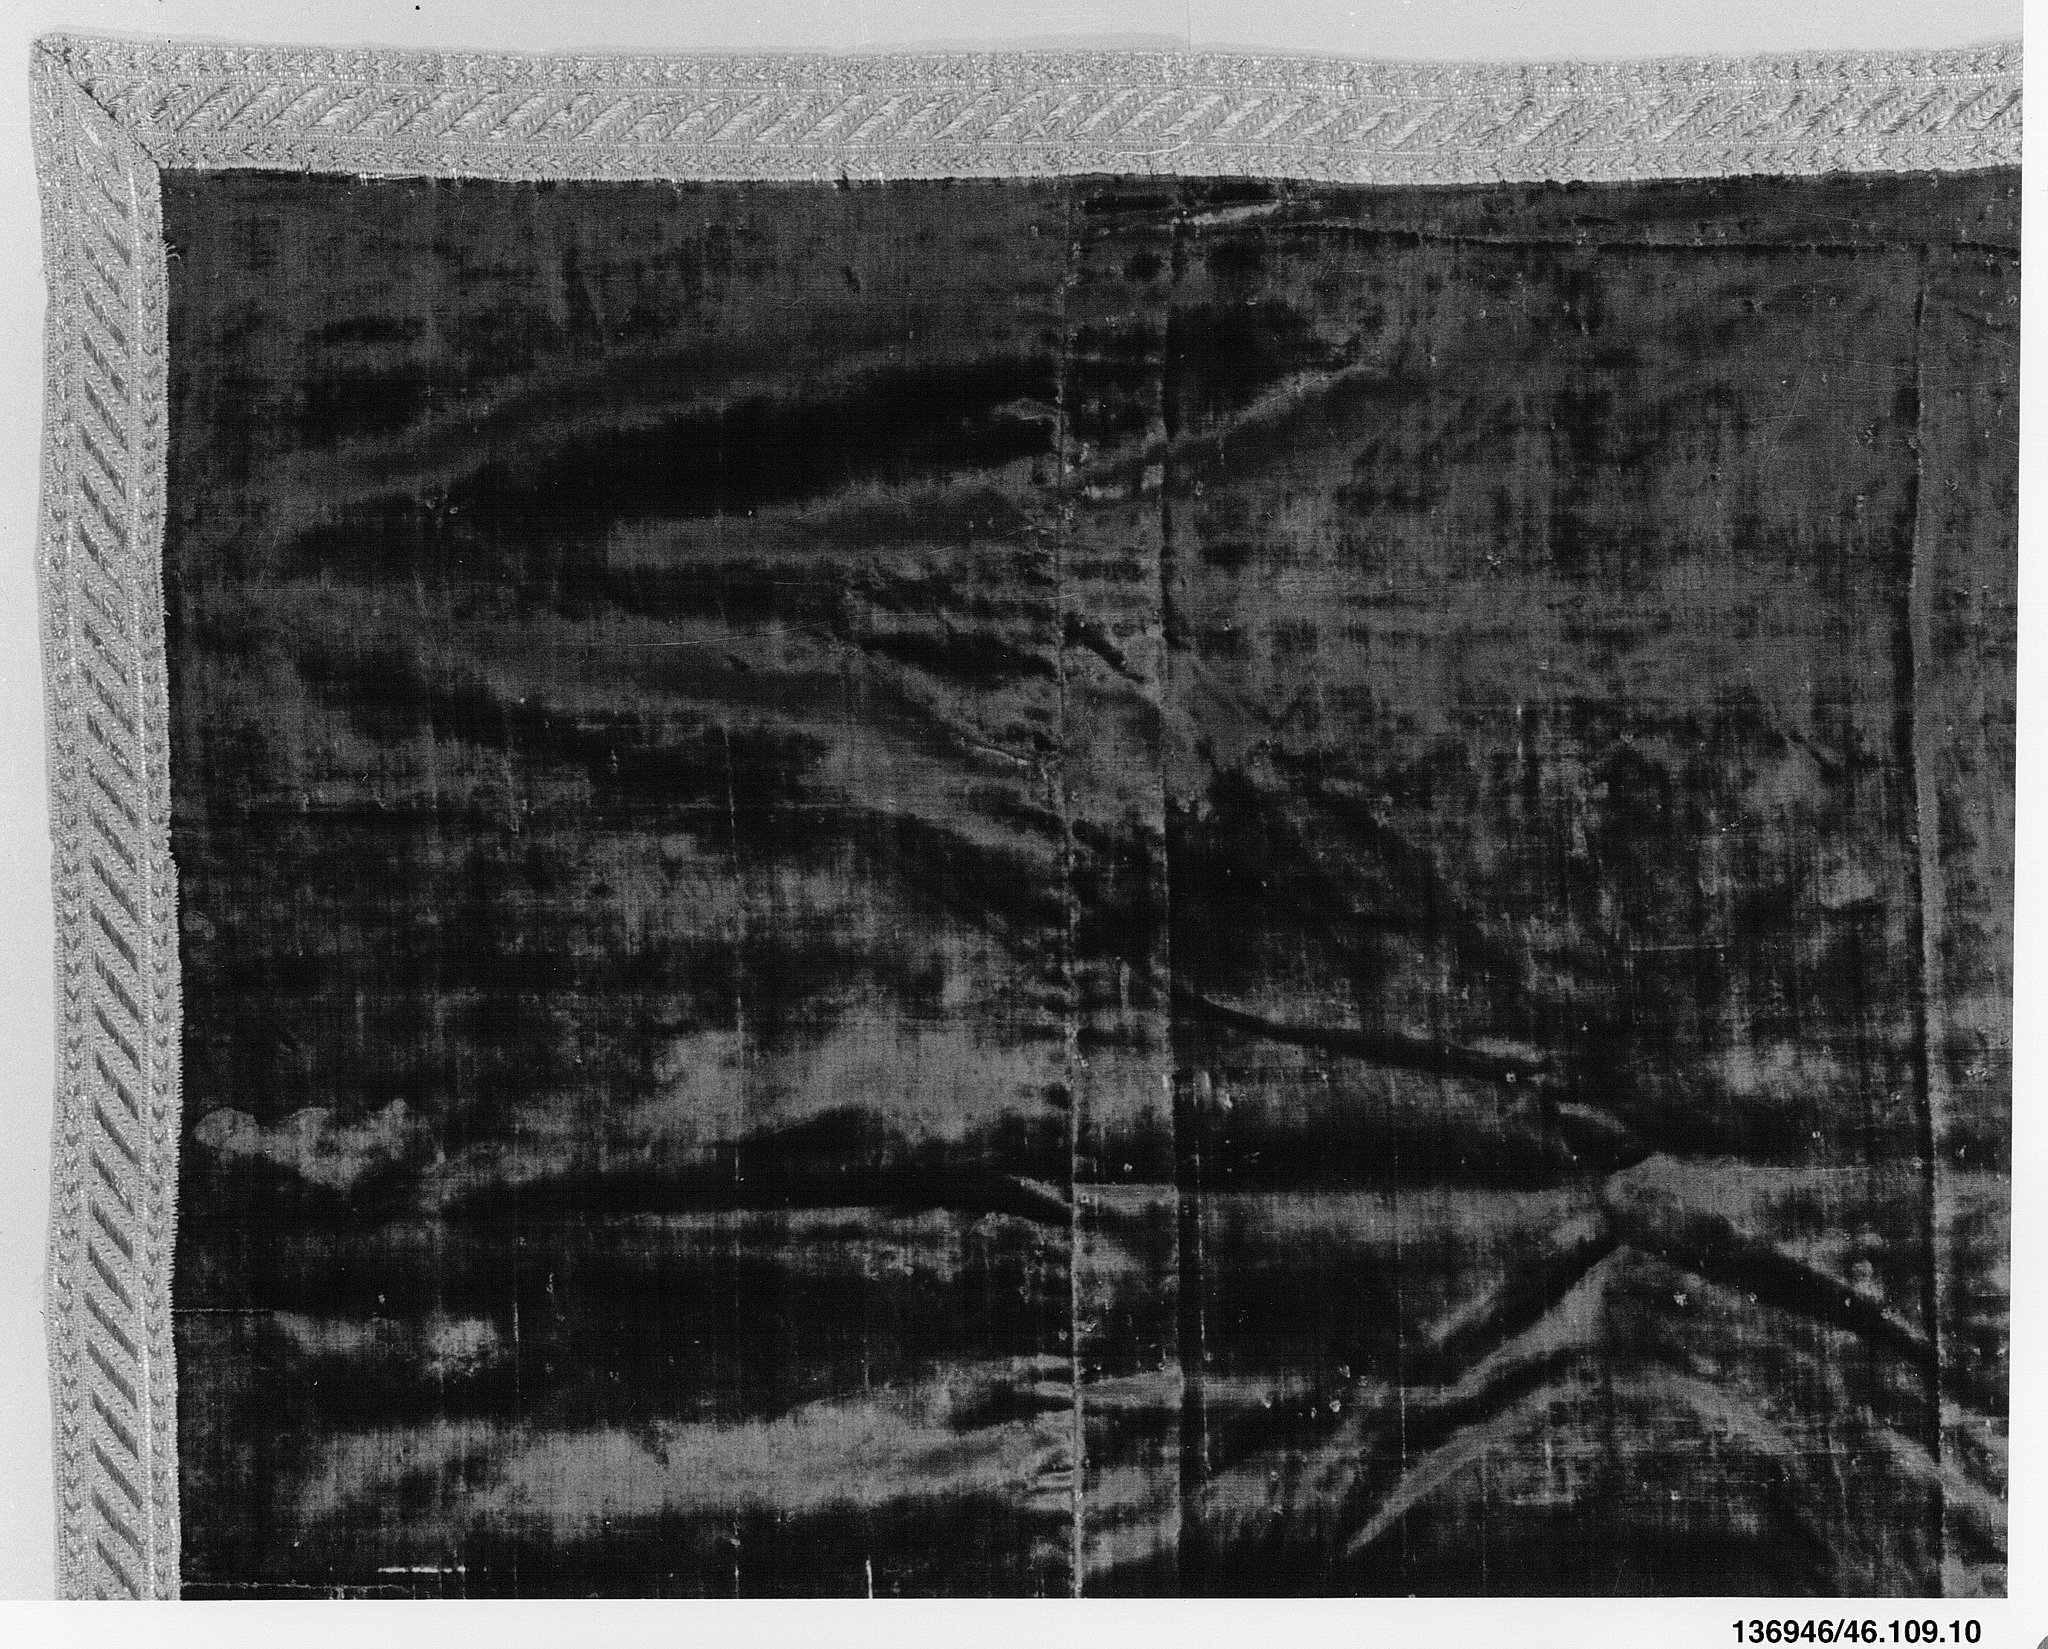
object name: piece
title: Panel of crimson velvet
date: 1575-1624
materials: silk